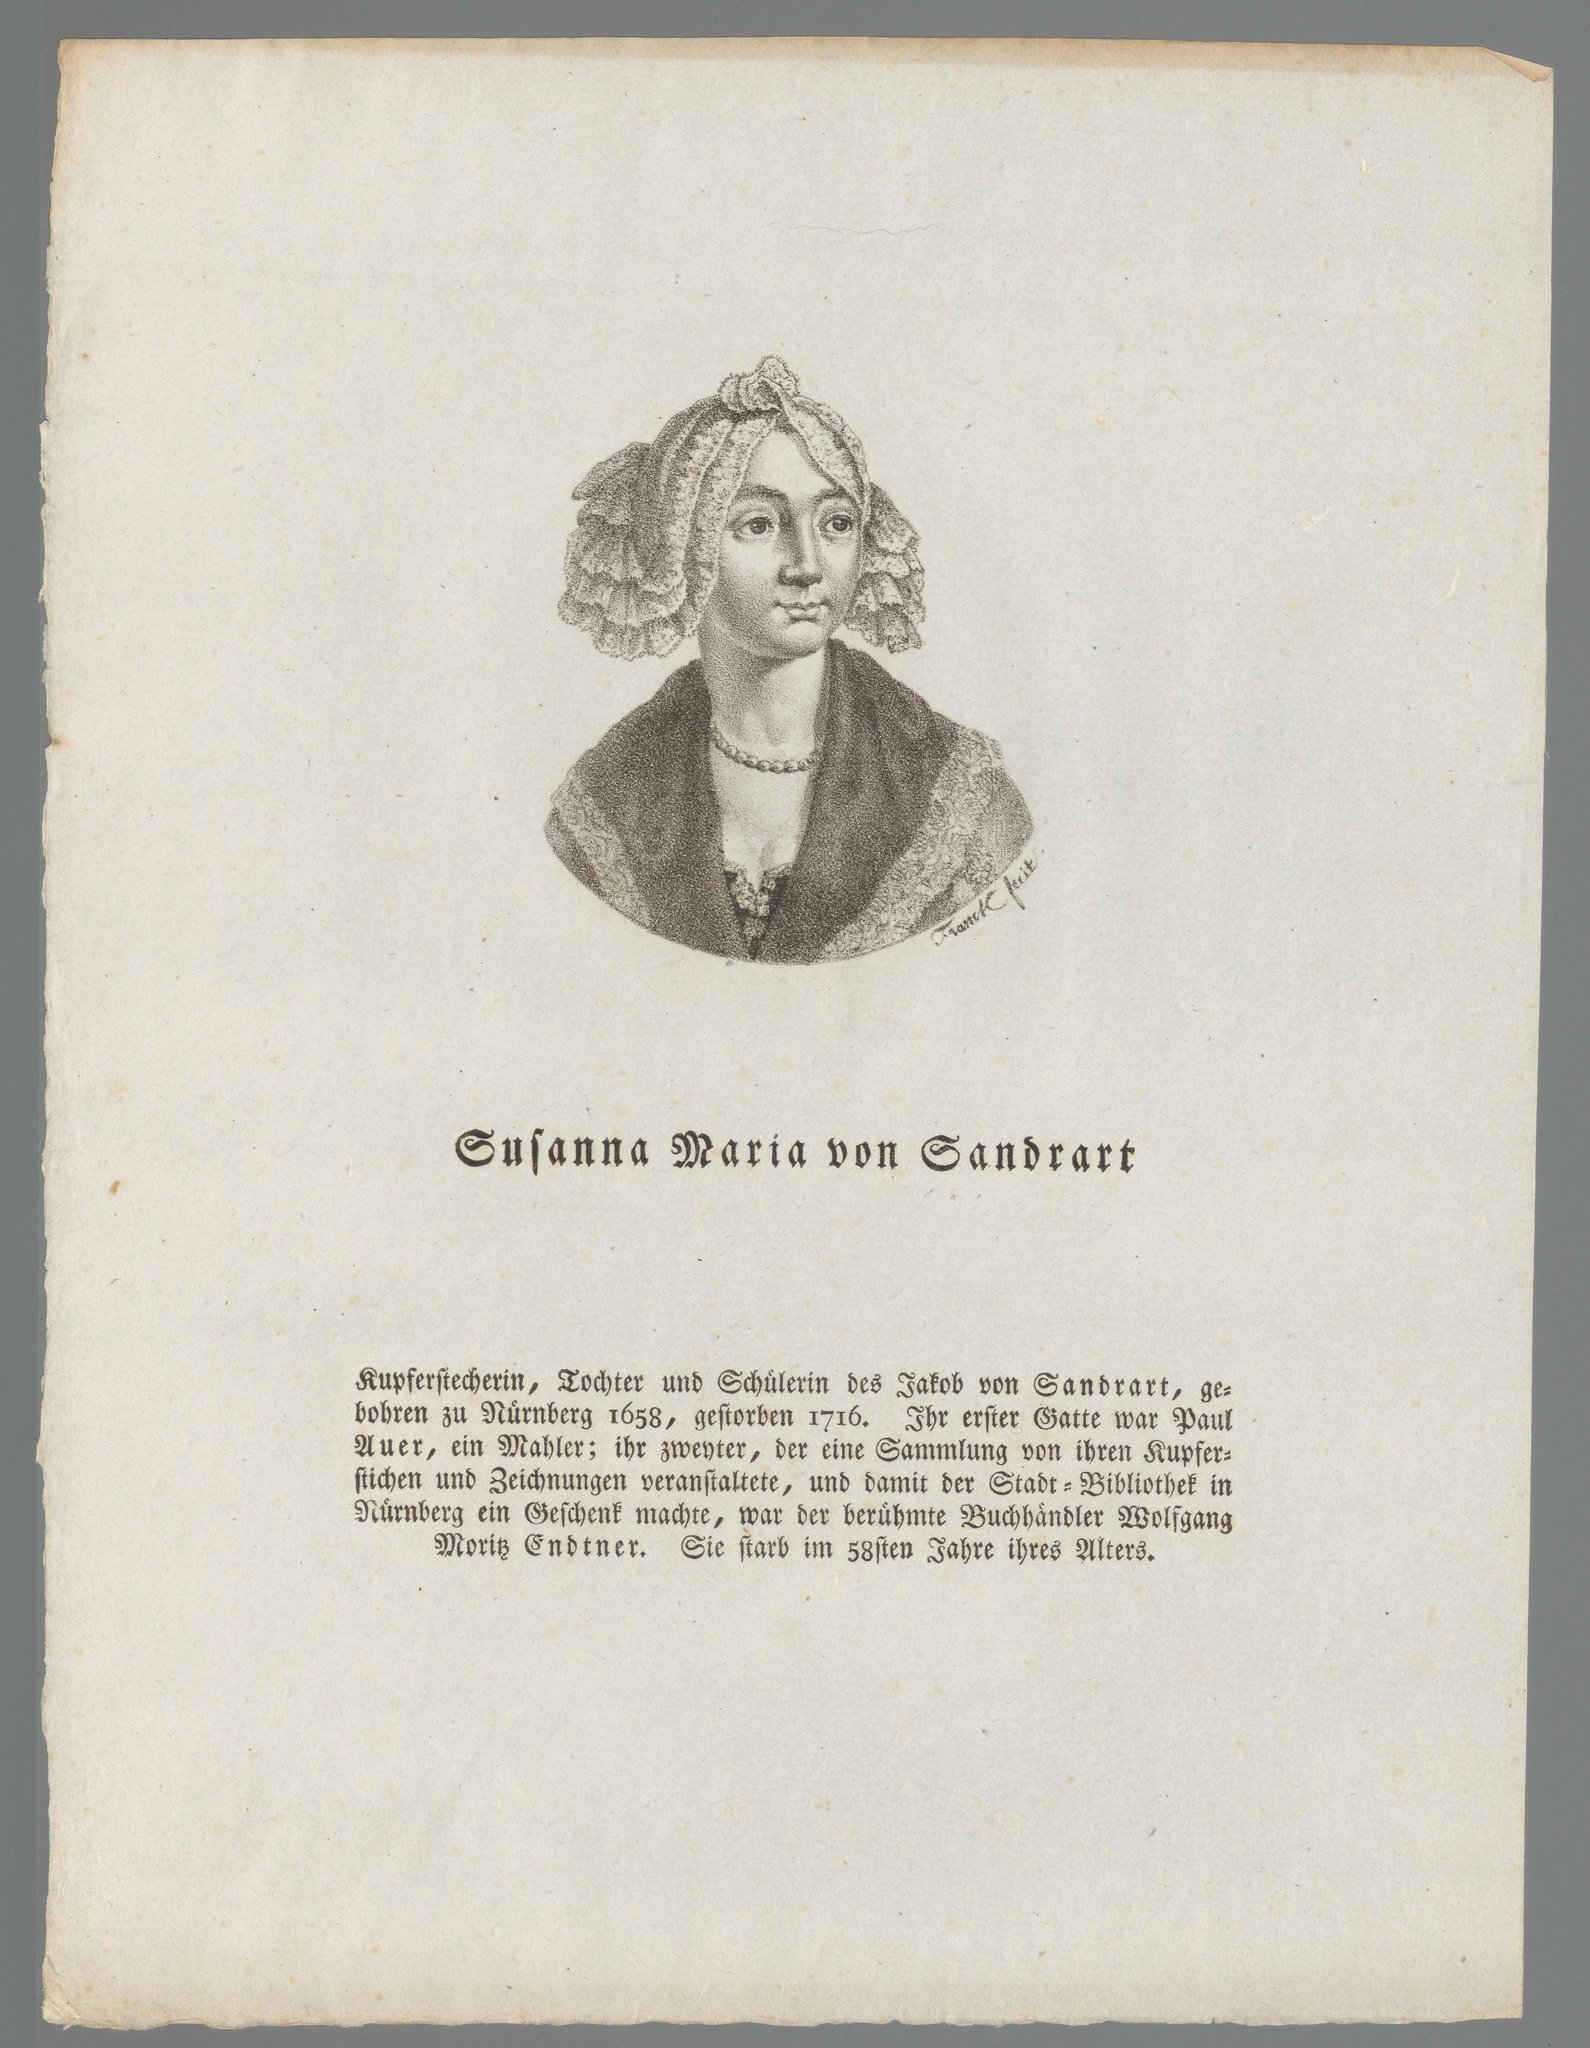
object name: print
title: Portret van Susanne Maria von Sandrart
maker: maximilian franck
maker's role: print maker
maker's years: 1780-1830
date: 1813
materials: paper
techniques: letterpress printing, lithograph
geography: munich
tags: print maker, susanne maria von sandrart, historical persons, portrait, self-portrait of graphic artist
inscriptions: collector's mark: Lugt 2228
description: Prent uit: Lindauer, Joseph. Deutsche Künstler-Gallerie. München: Maximilian Franck, 1813.